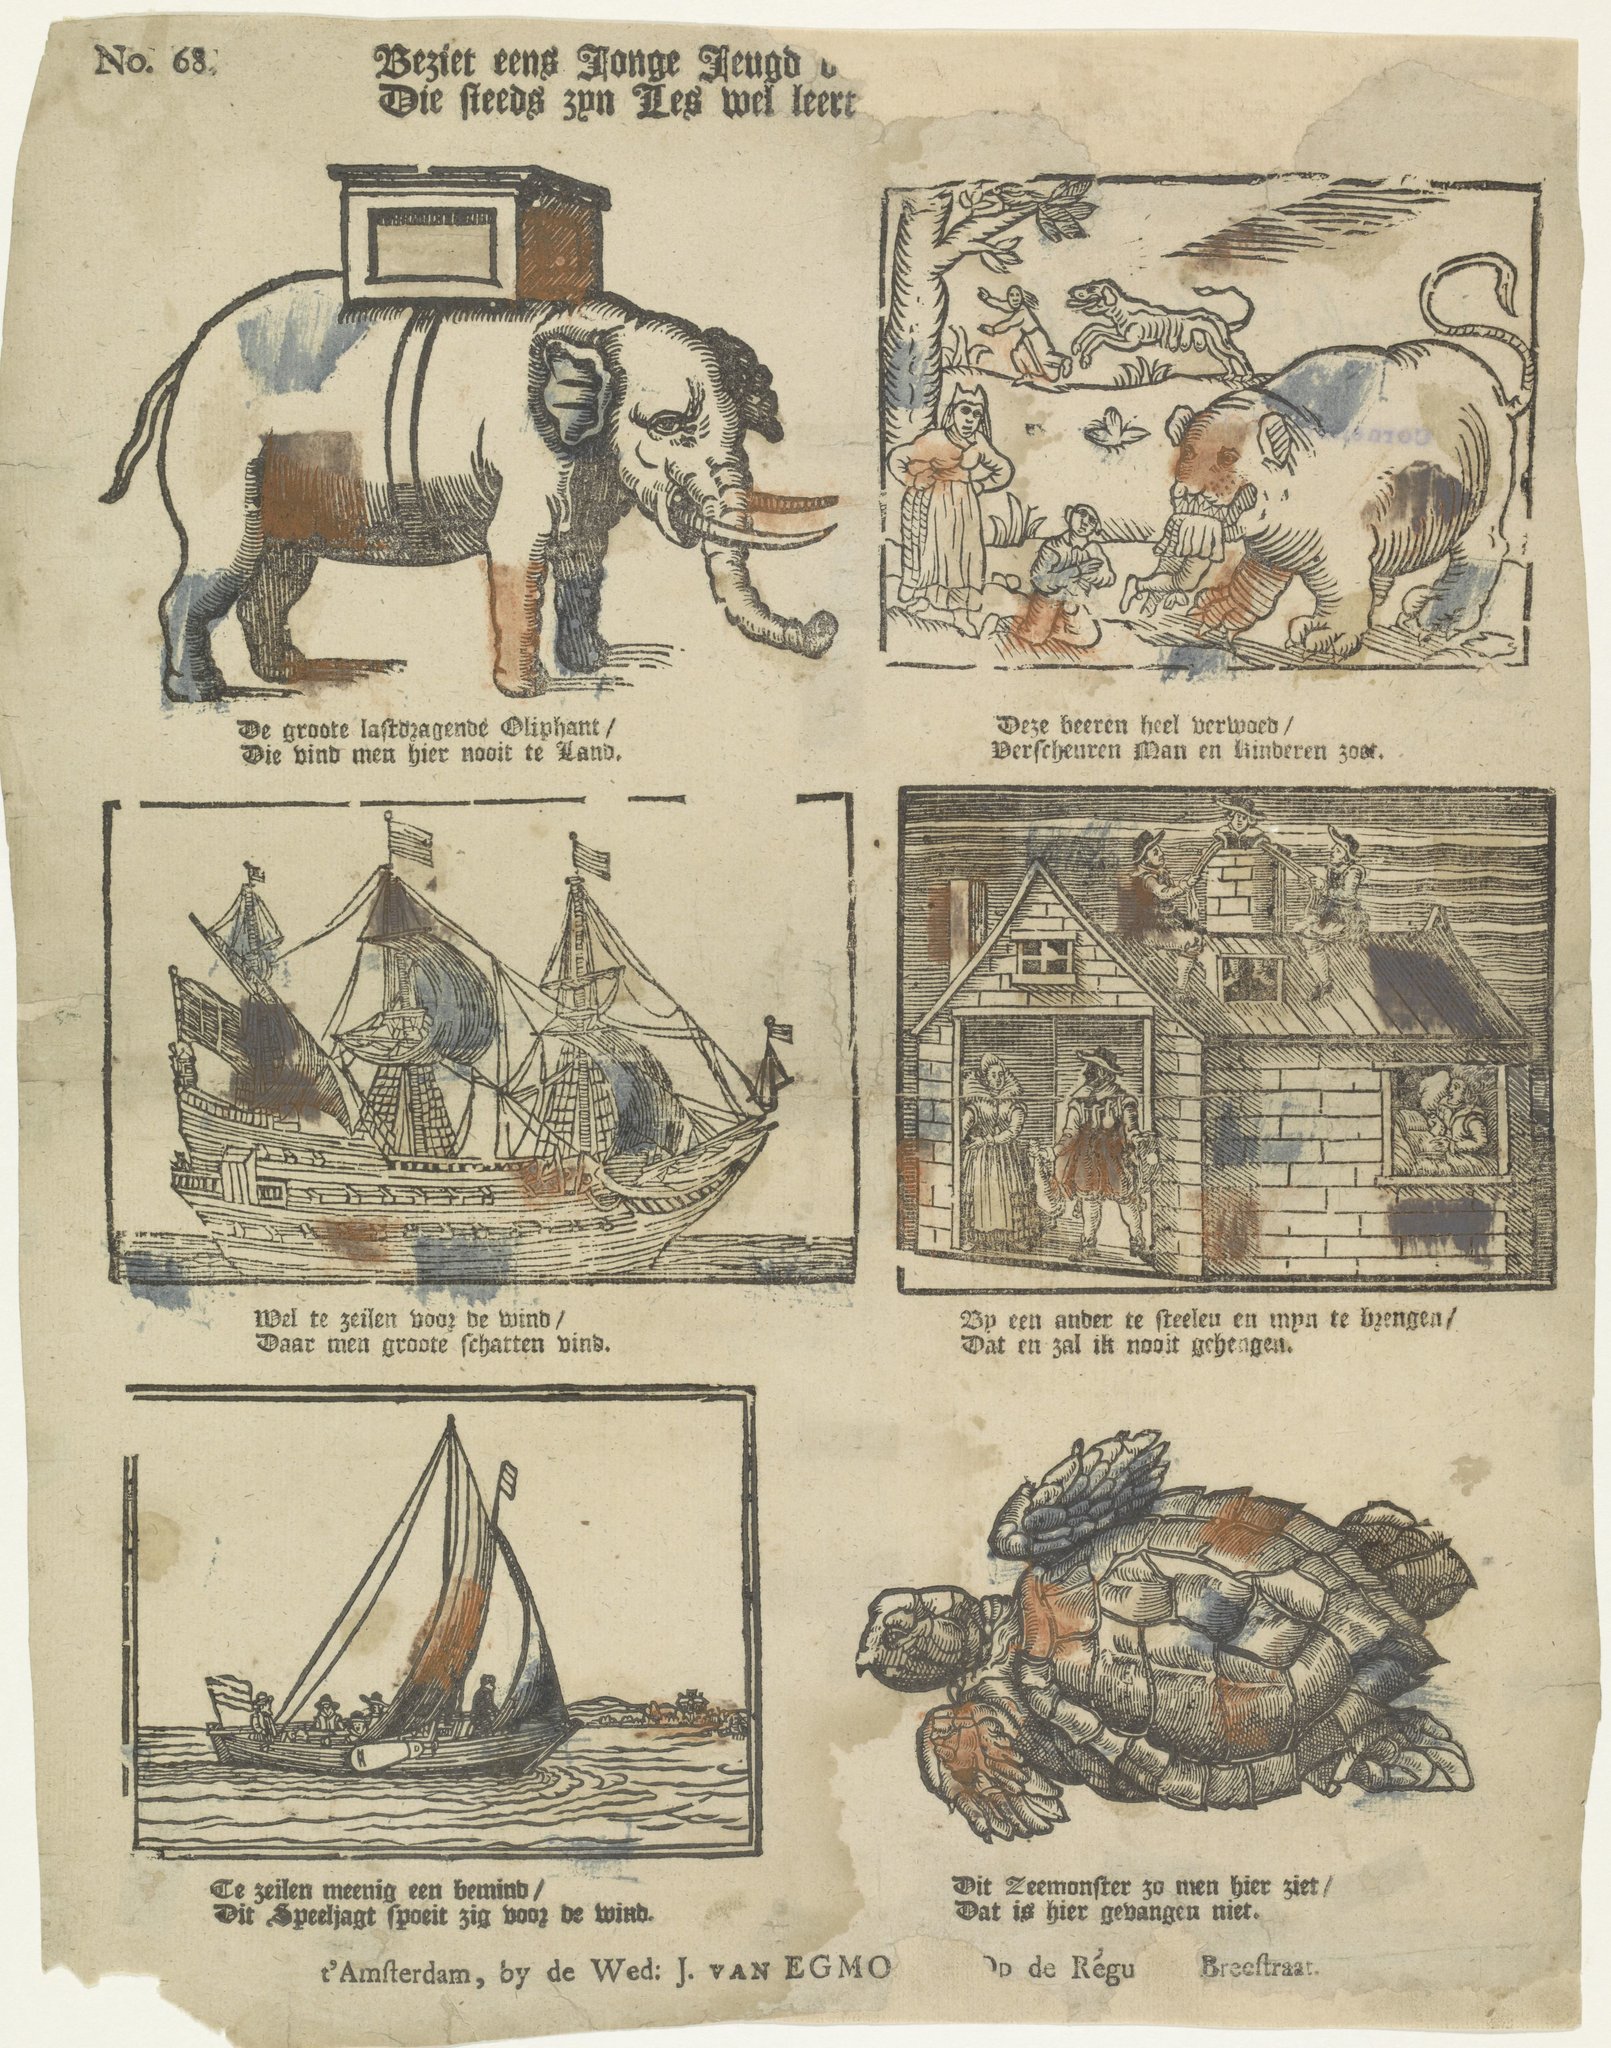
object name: print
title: Beziet eens Jonge Jeugd (...)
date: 1558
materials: paper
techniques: colour, letterpress printing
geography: amsterdam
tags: animals, tortoises, turtles, ships (in general), trunked animals: elephant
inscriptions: collector's mark: Lugt 2228, collector's mark: Lugt 2760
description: Voor het drukken van deze prent is gebruik gemaakt van bestaande houtblokken. Voor de schildpad is gebruik gemaakt van een houtblok dat in de zestiende eeuw gebruikt werd voor de befaamde natuurhistorische boeken van de Zwitser Conrad Gessner. Minstens een deel van de houtblokken voor de illustraties van Gessners werk bevond zich in de achttiende en vroege negentiende eeuw in Nederland. Daar werden ze benut voor het drukken van cents- of volksprenten. De nogal willekeurige kleuring op de prenten is typerend voor dit soort goedkope grafiek. Opvallend is dat de dieren in de tekstjes die onder de afbeeldingen werden toegevoegd vaak anders zijn geduid dan bij Gessner. De schildpad komt voor in verschillende publicaties van Gessner, alsmede herdrukken daarvan, zoals het vierde deel van Historiae animalium (eerste uitgave 1558).